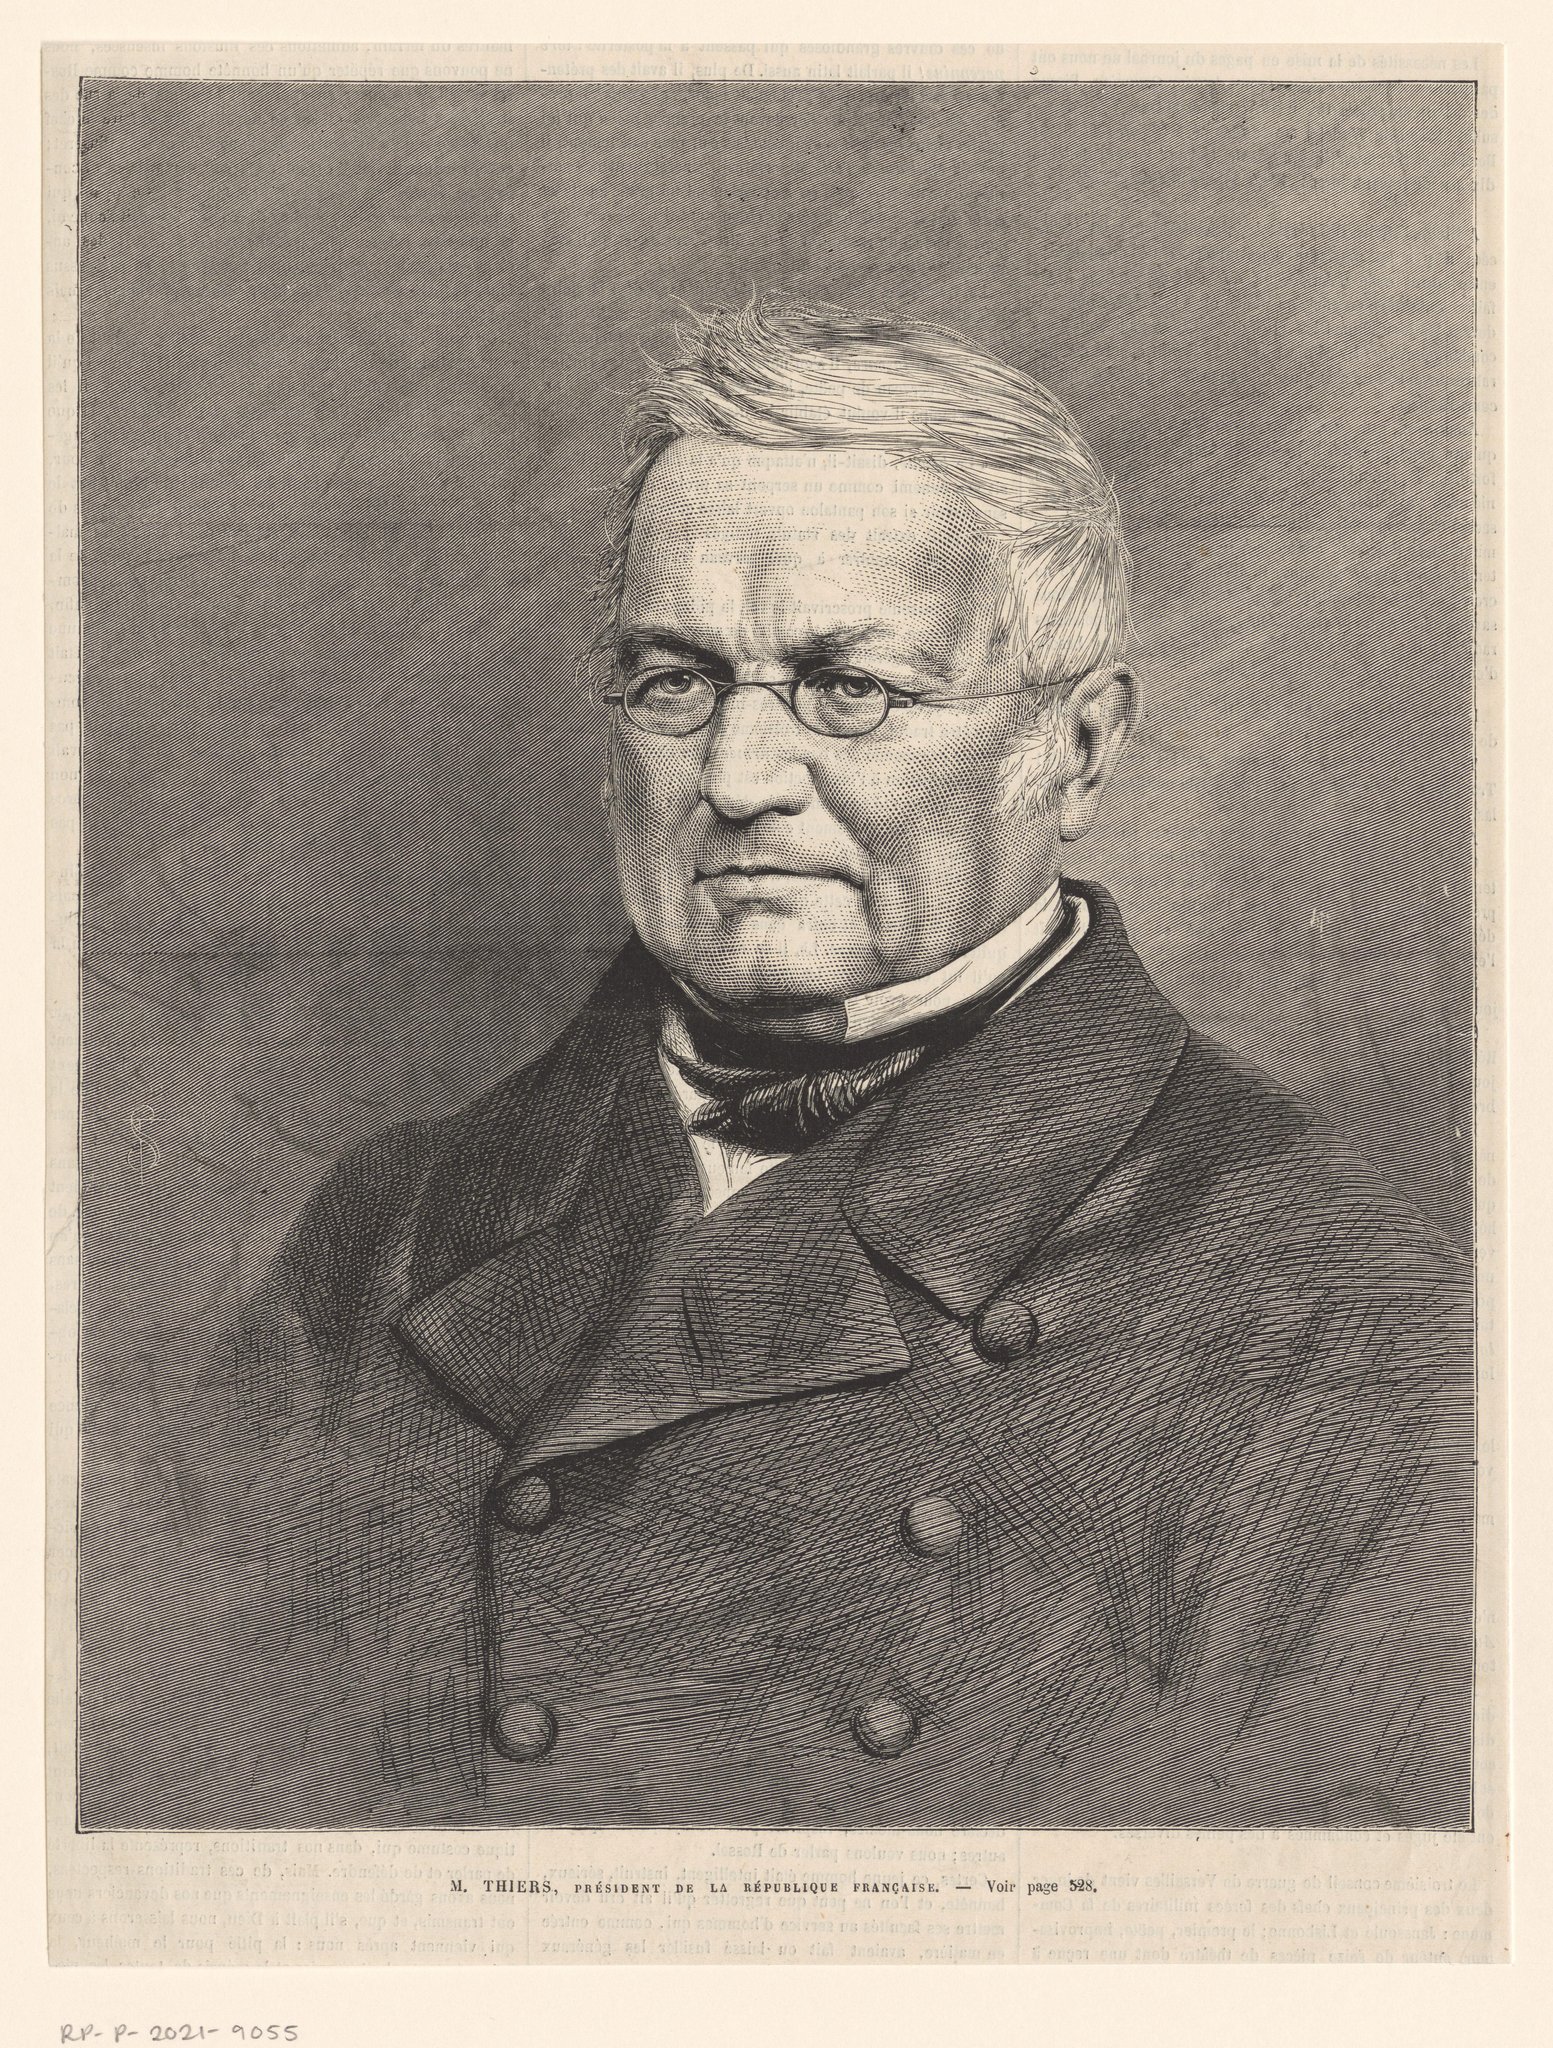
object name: print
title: Portret van Adolphe Thiers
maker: Anonymous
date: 1871-1873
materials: paper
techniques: letterpress printing, engraving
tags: marseille, politician, eyeglasses, spectacles, historical persons, politician, e.g. party leader